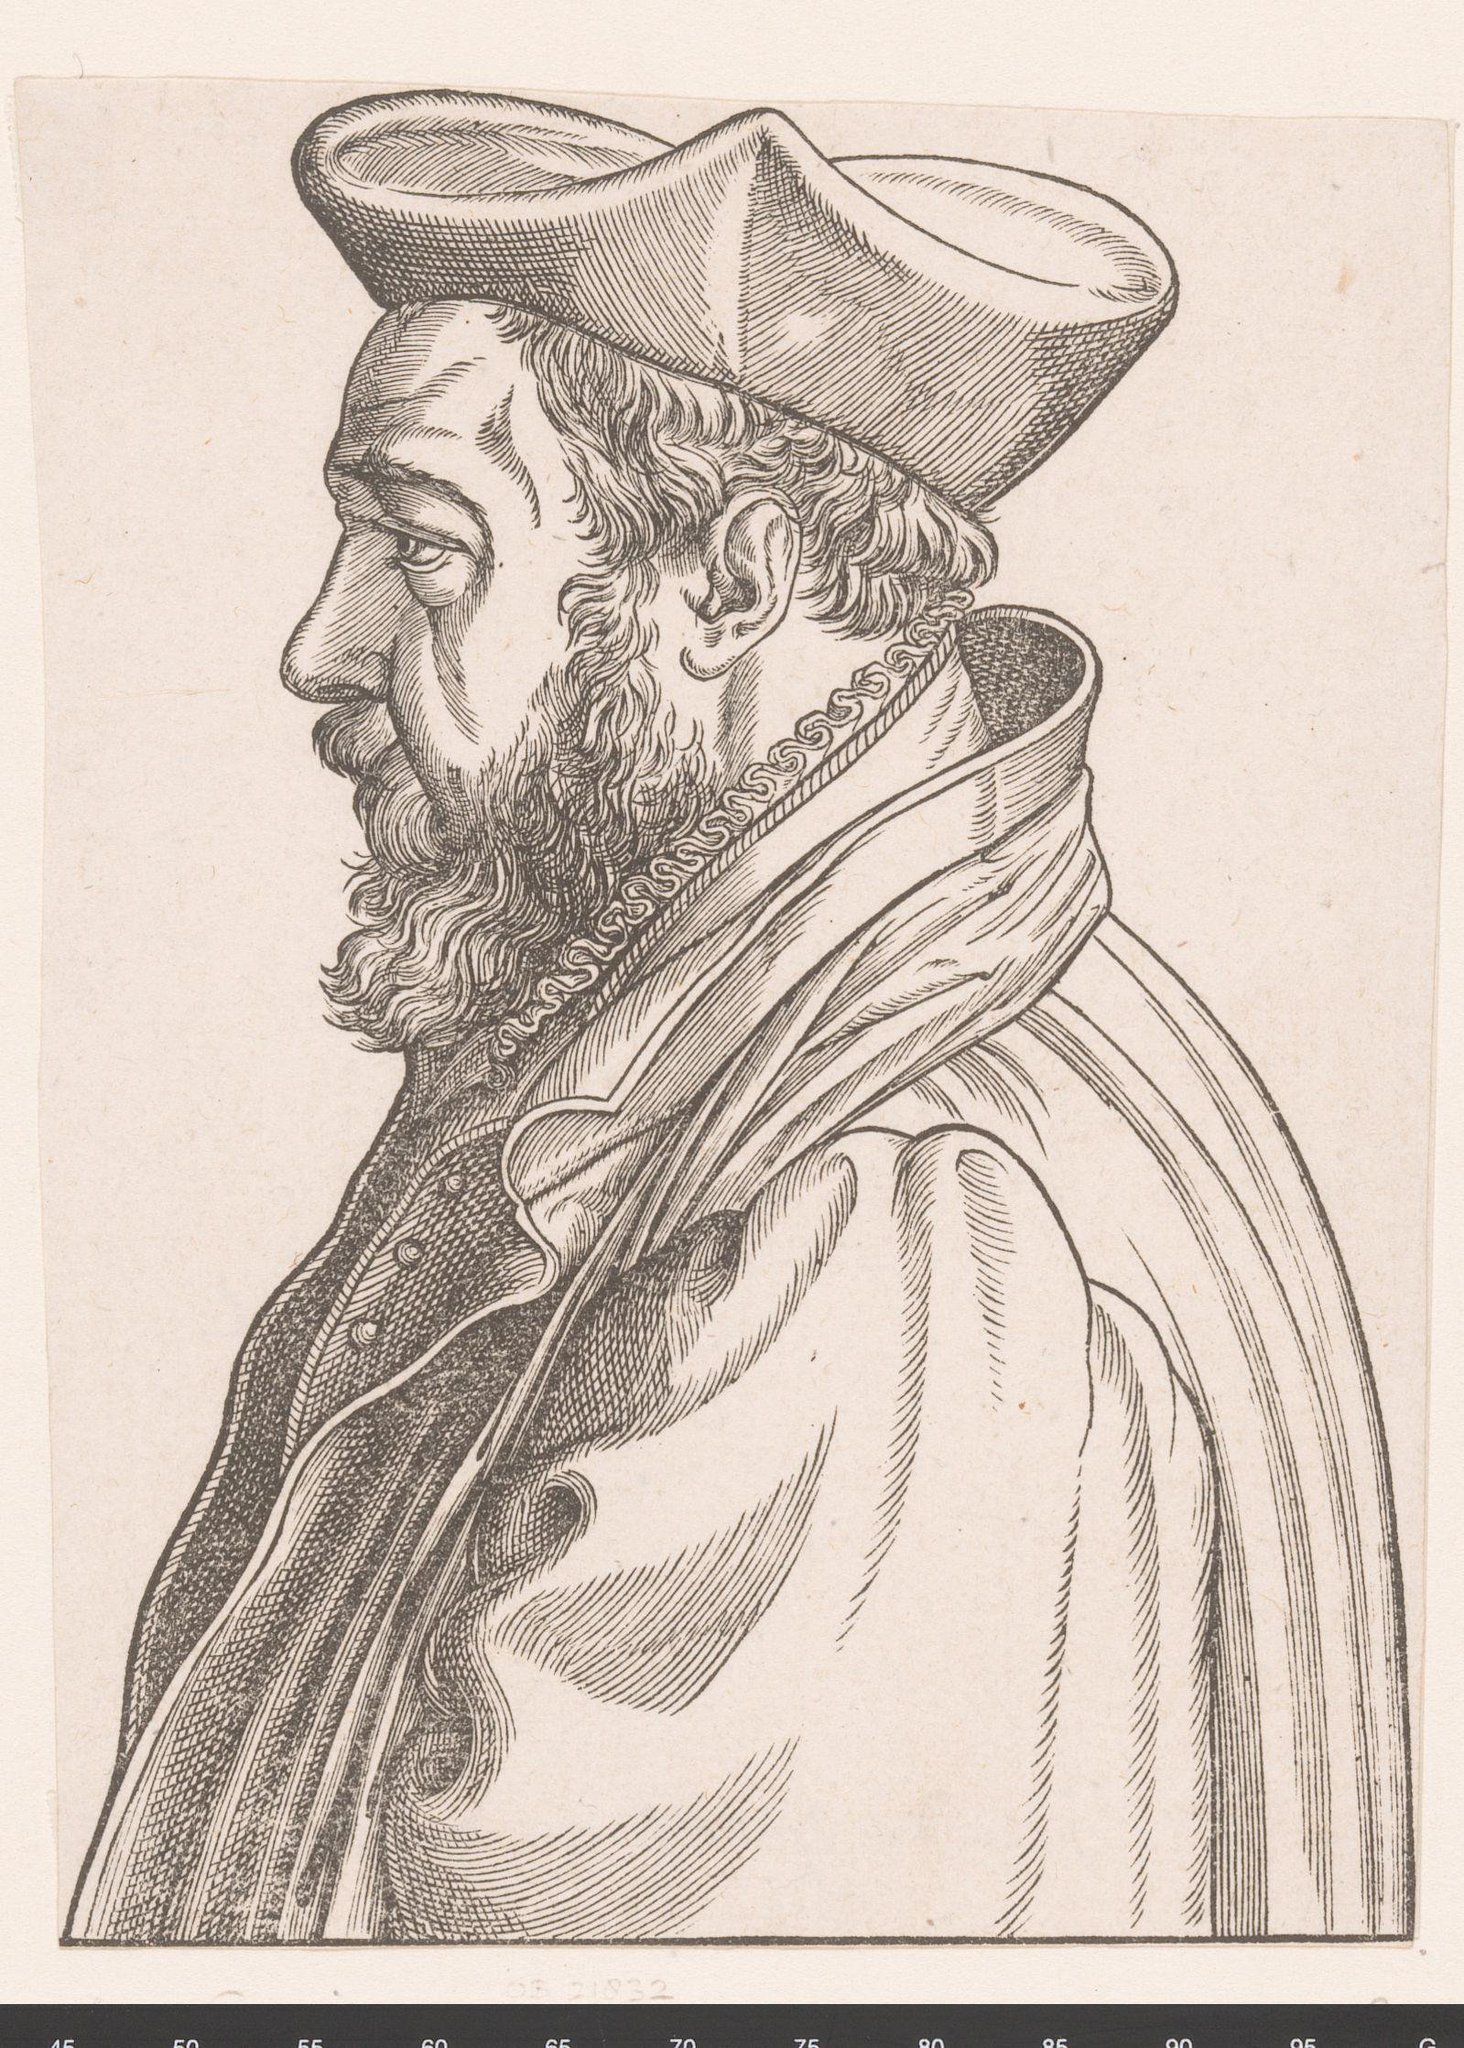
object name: print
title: Portret van Jean de Gorris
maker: andré wechel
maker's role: publisher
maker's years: 1510-1581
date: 1520-1581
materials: paper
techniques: woodcut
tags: paris, historical persons